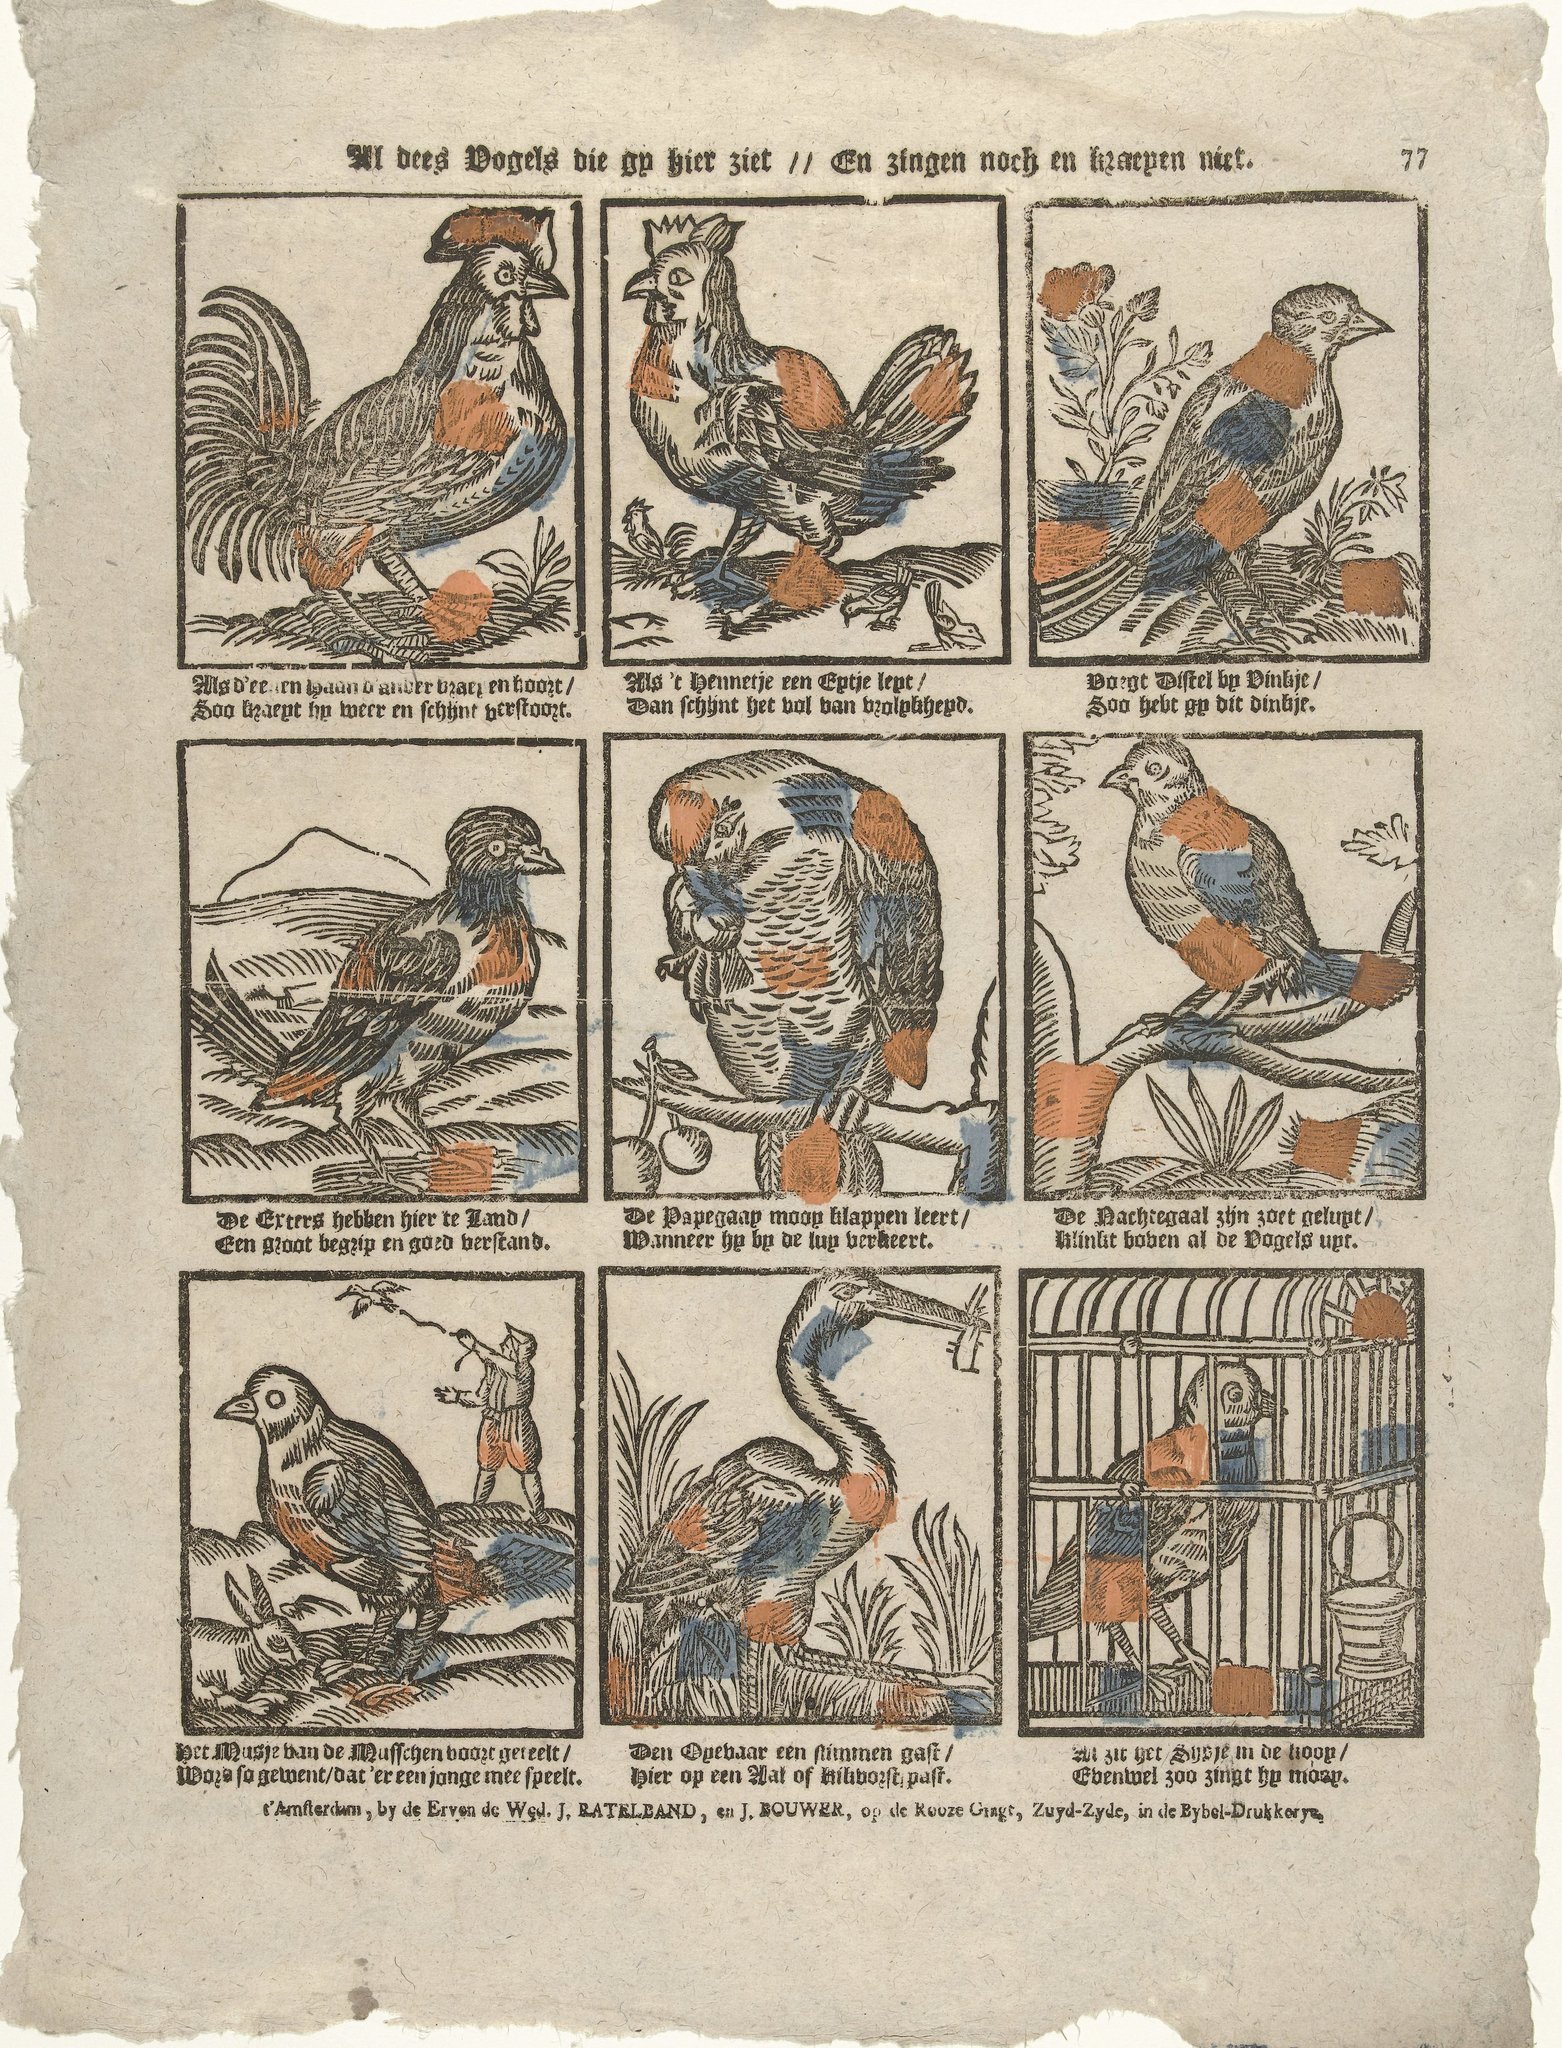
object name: popular print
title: Al dees vogels die gy hier ziet // En zingen noch en kreayen niet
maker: Anonymous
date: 1782-1793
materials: paper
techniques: colour, letterpress printing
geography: amsterdam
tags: birds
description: Blad met 9 voorstellingen van vogels, zoals een haan, een papegaai en een musje. Onder elke afbeelding een tweeregelig vers. Genummerd rechtsboven: 77.